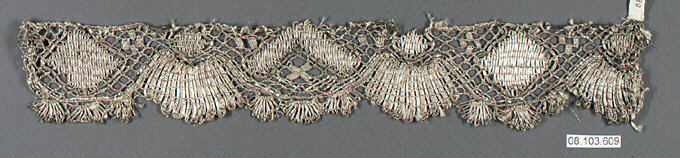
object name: piece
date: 1701-1800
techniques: lace